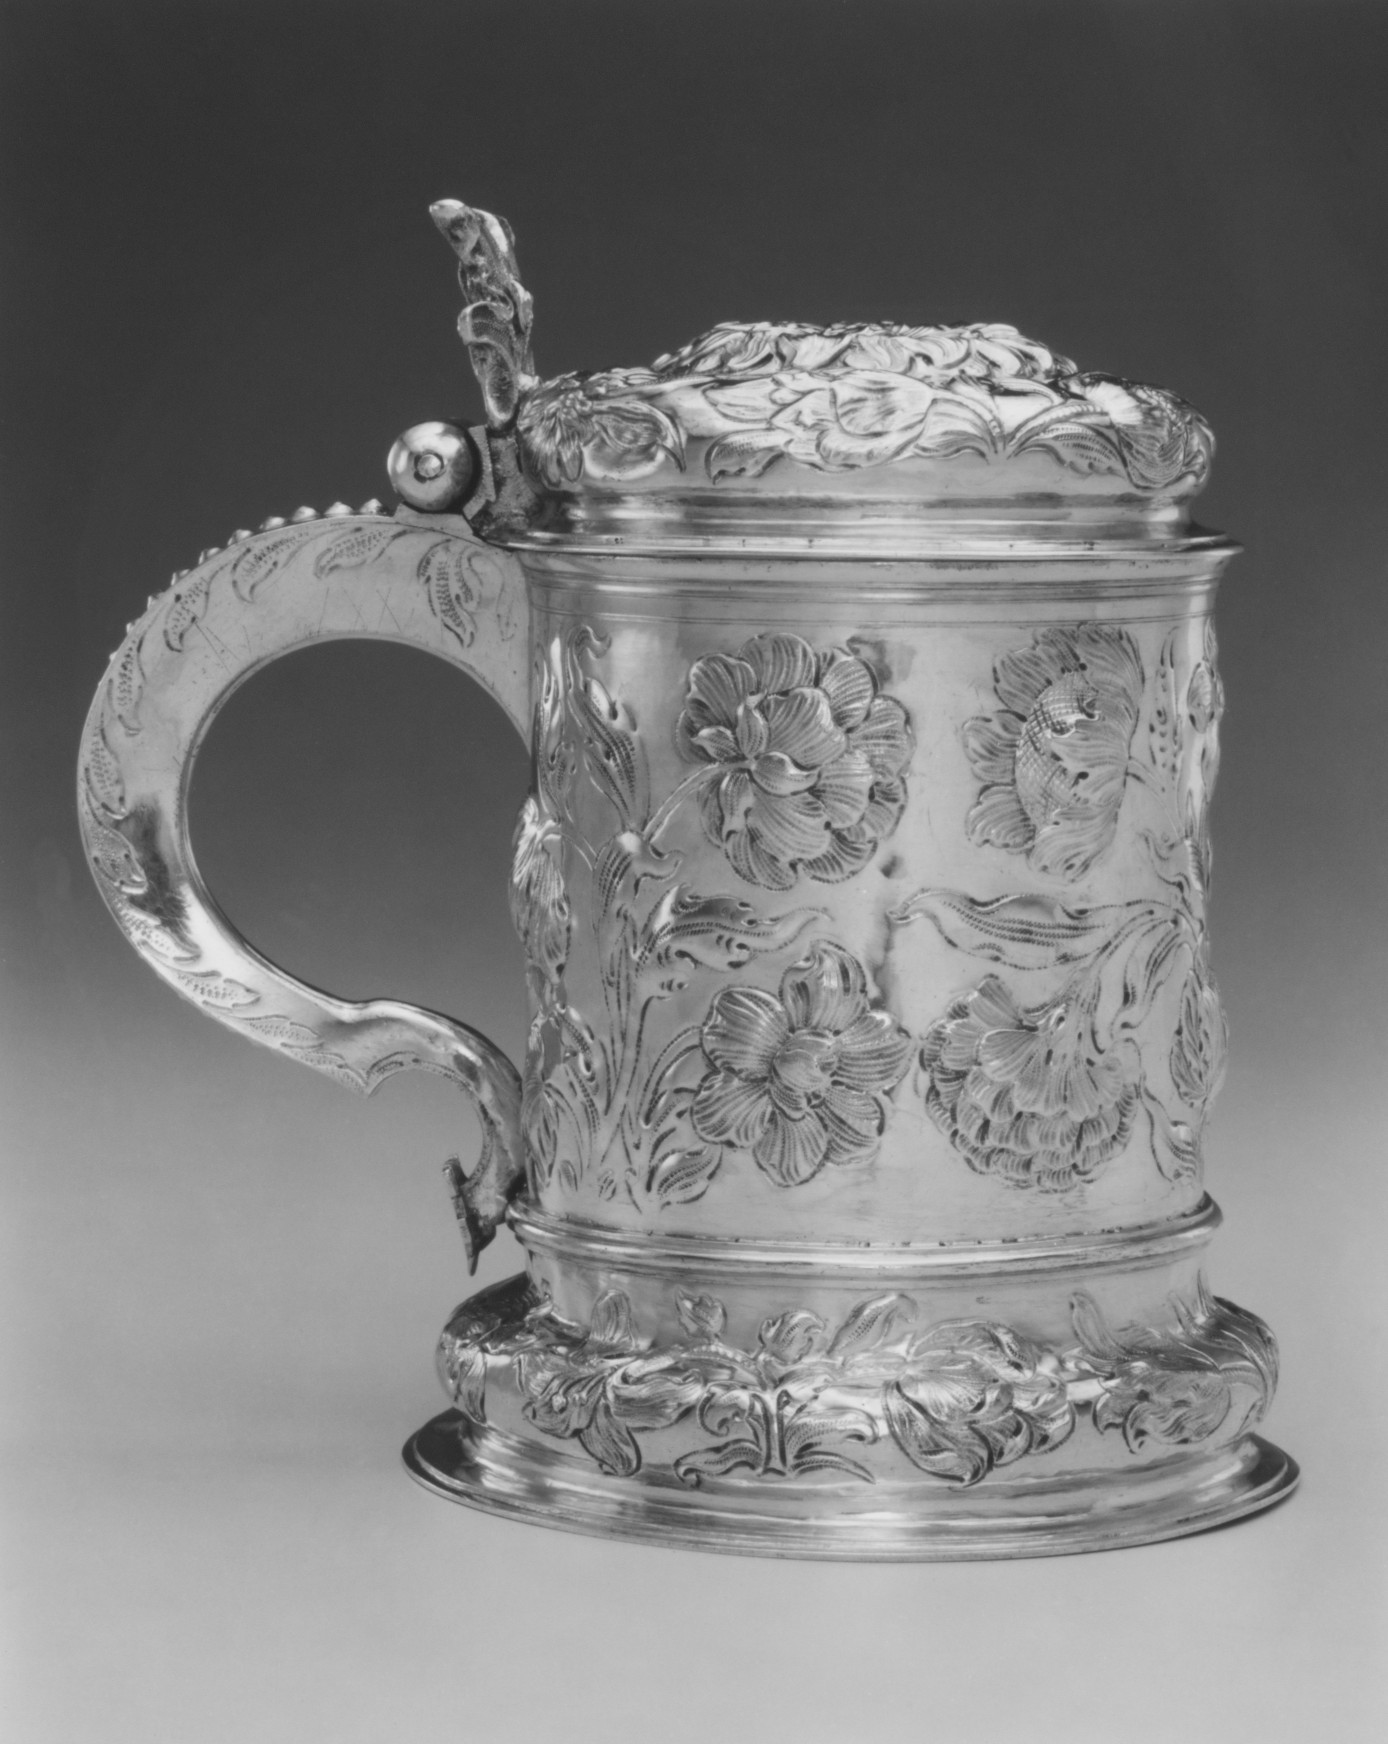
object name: tankard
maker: hanss lambrecht iii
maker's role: maker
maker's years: 1630-1670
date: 1660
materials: silver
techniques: gilding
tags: flowers